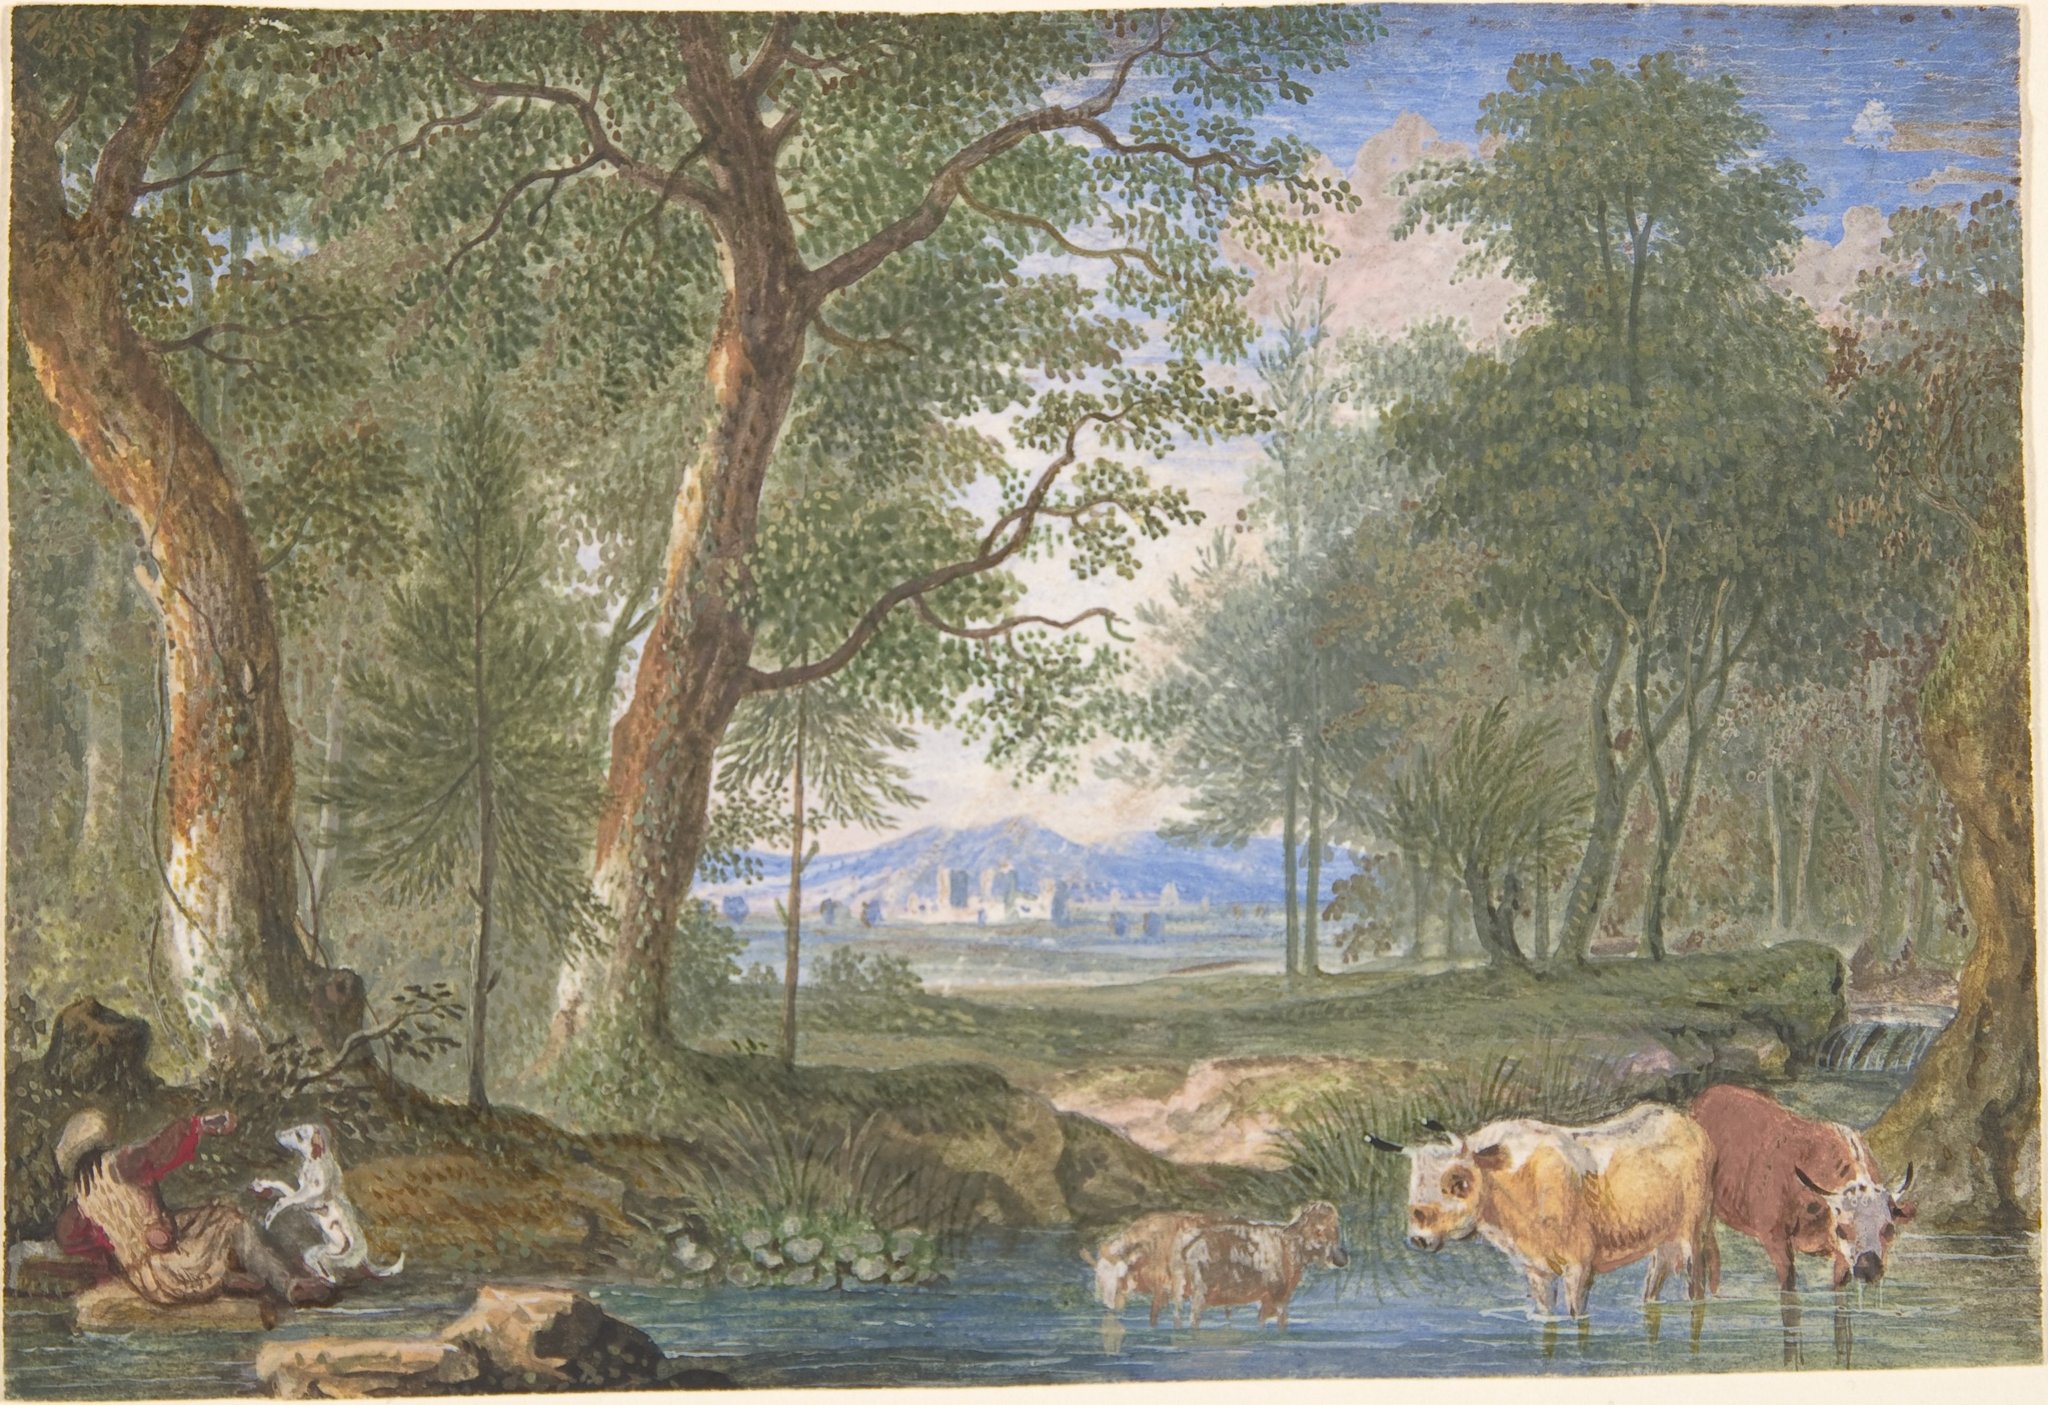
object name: drawing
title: Landscape with Cows in a Brook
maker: felix meyer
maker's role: artist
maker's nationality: swiss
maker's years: 1653-1713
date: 1698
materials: gouache, gum arabic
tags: cows,landscapes